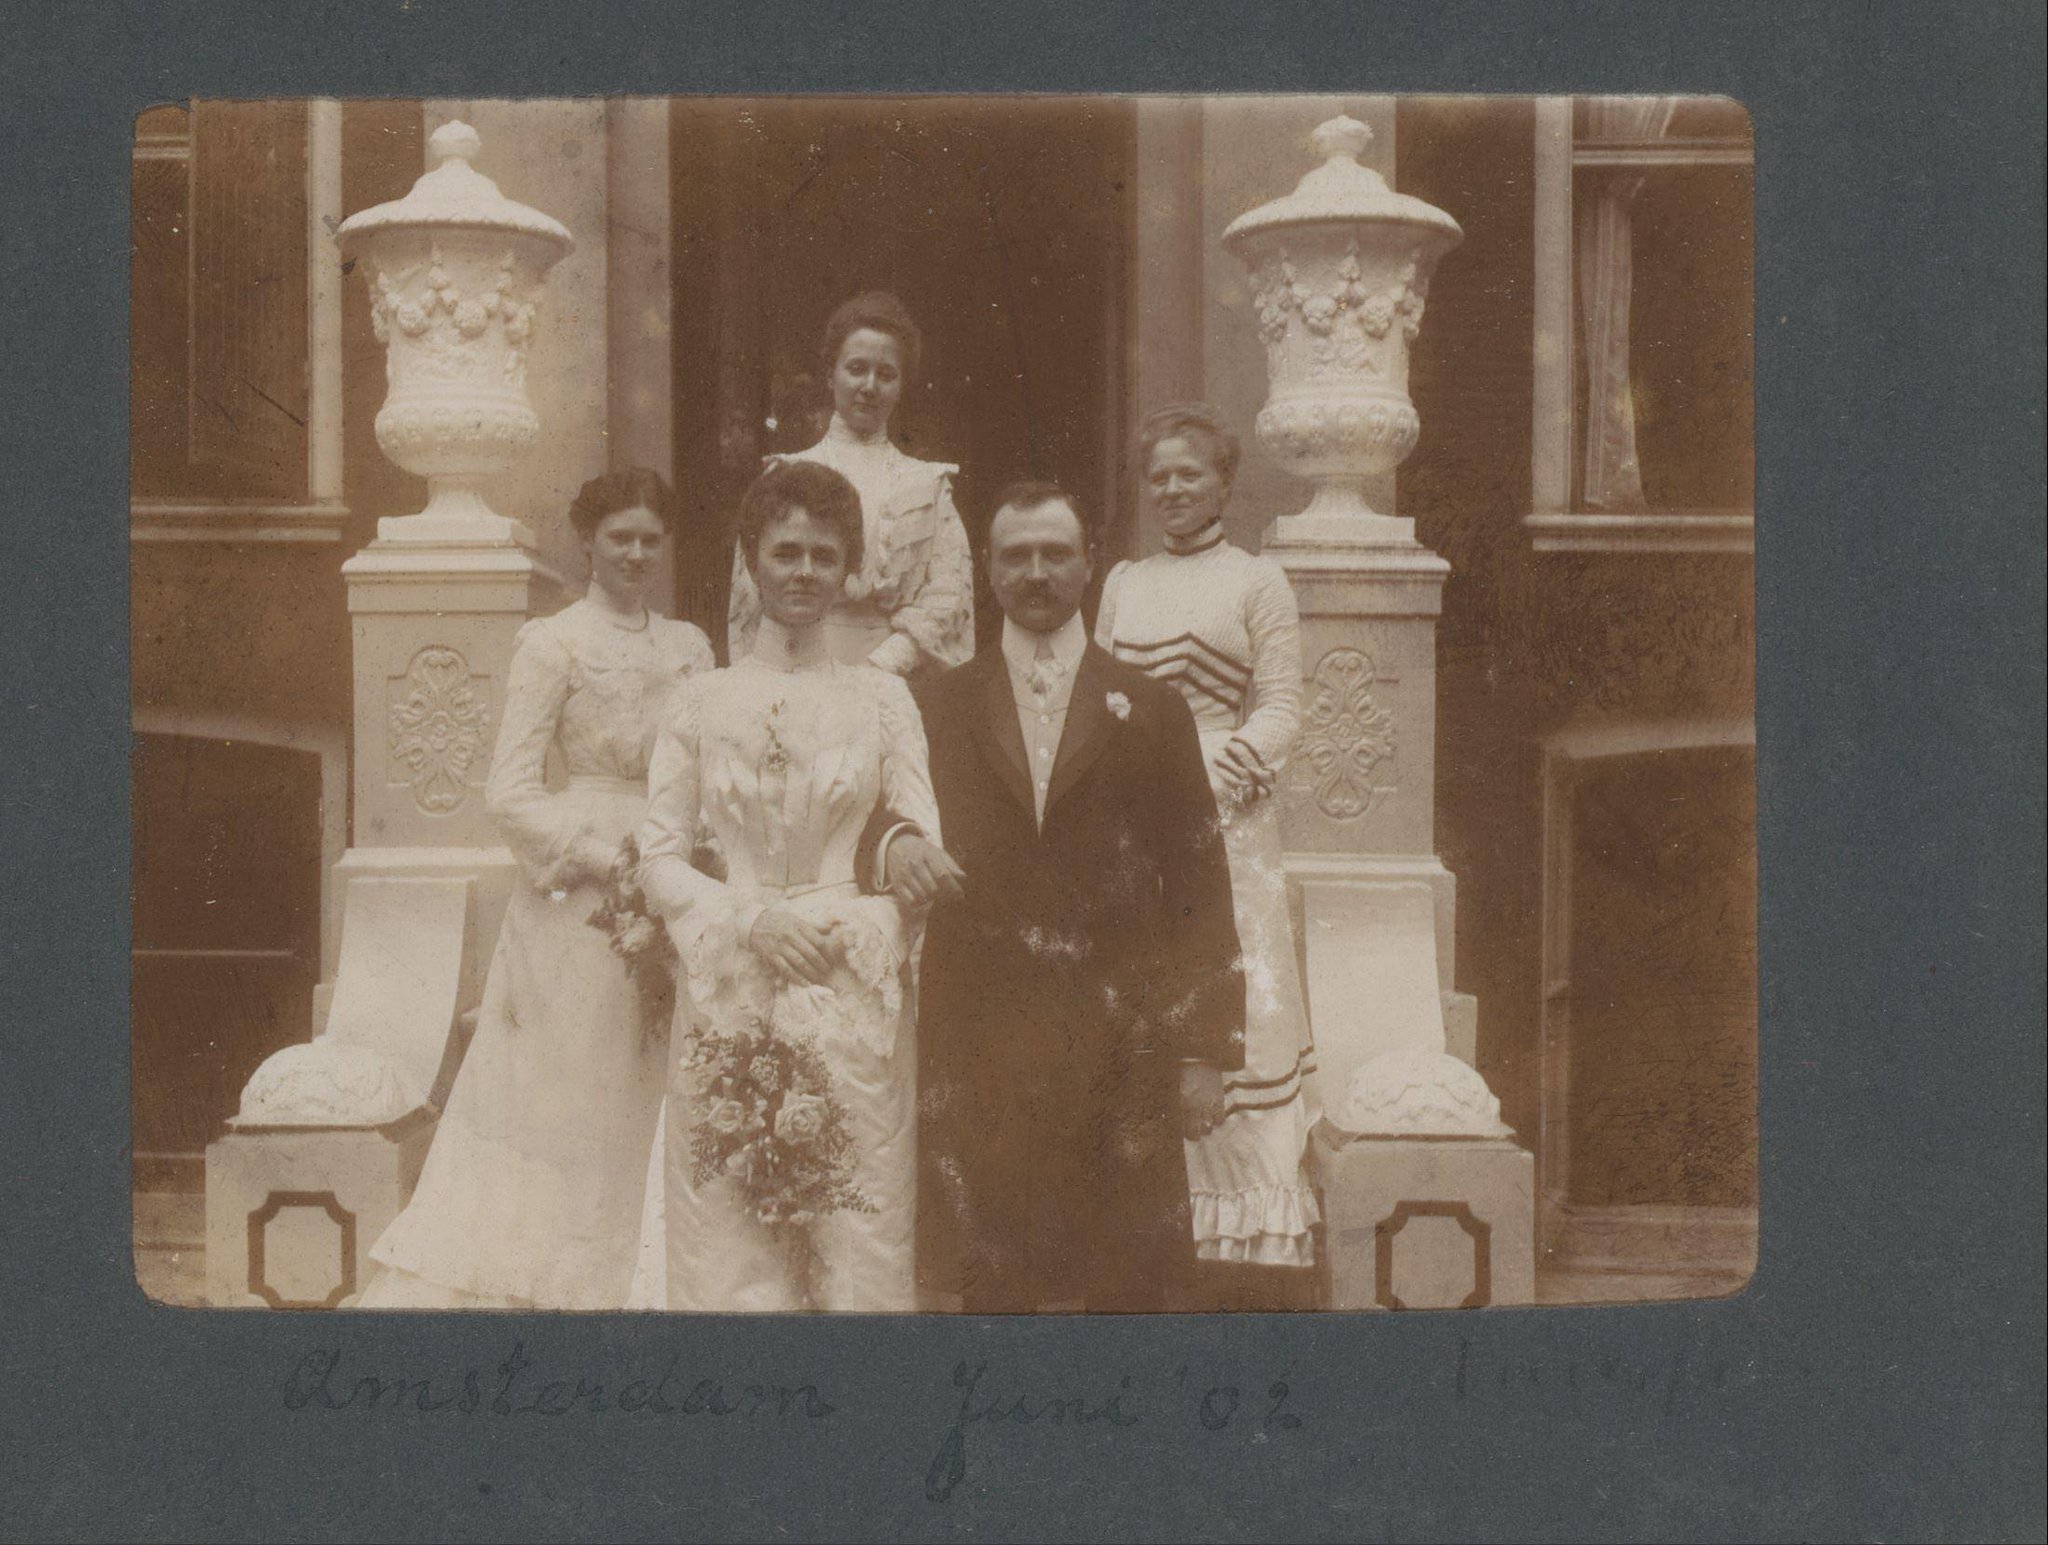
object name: album leaf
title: Portret van een bruidspaar met gasten in Amsterdam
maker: Anonymous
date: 1902-1906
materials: cardboard, paper, photographic support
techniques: collodion silver print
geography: amsterdam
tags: marriage, married couple, 'matrimonium', amsterdam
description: Onderdeel van Reisalbum van een Nederlandse familie met bezienswaardigheden in Europa, Egypte en New York.